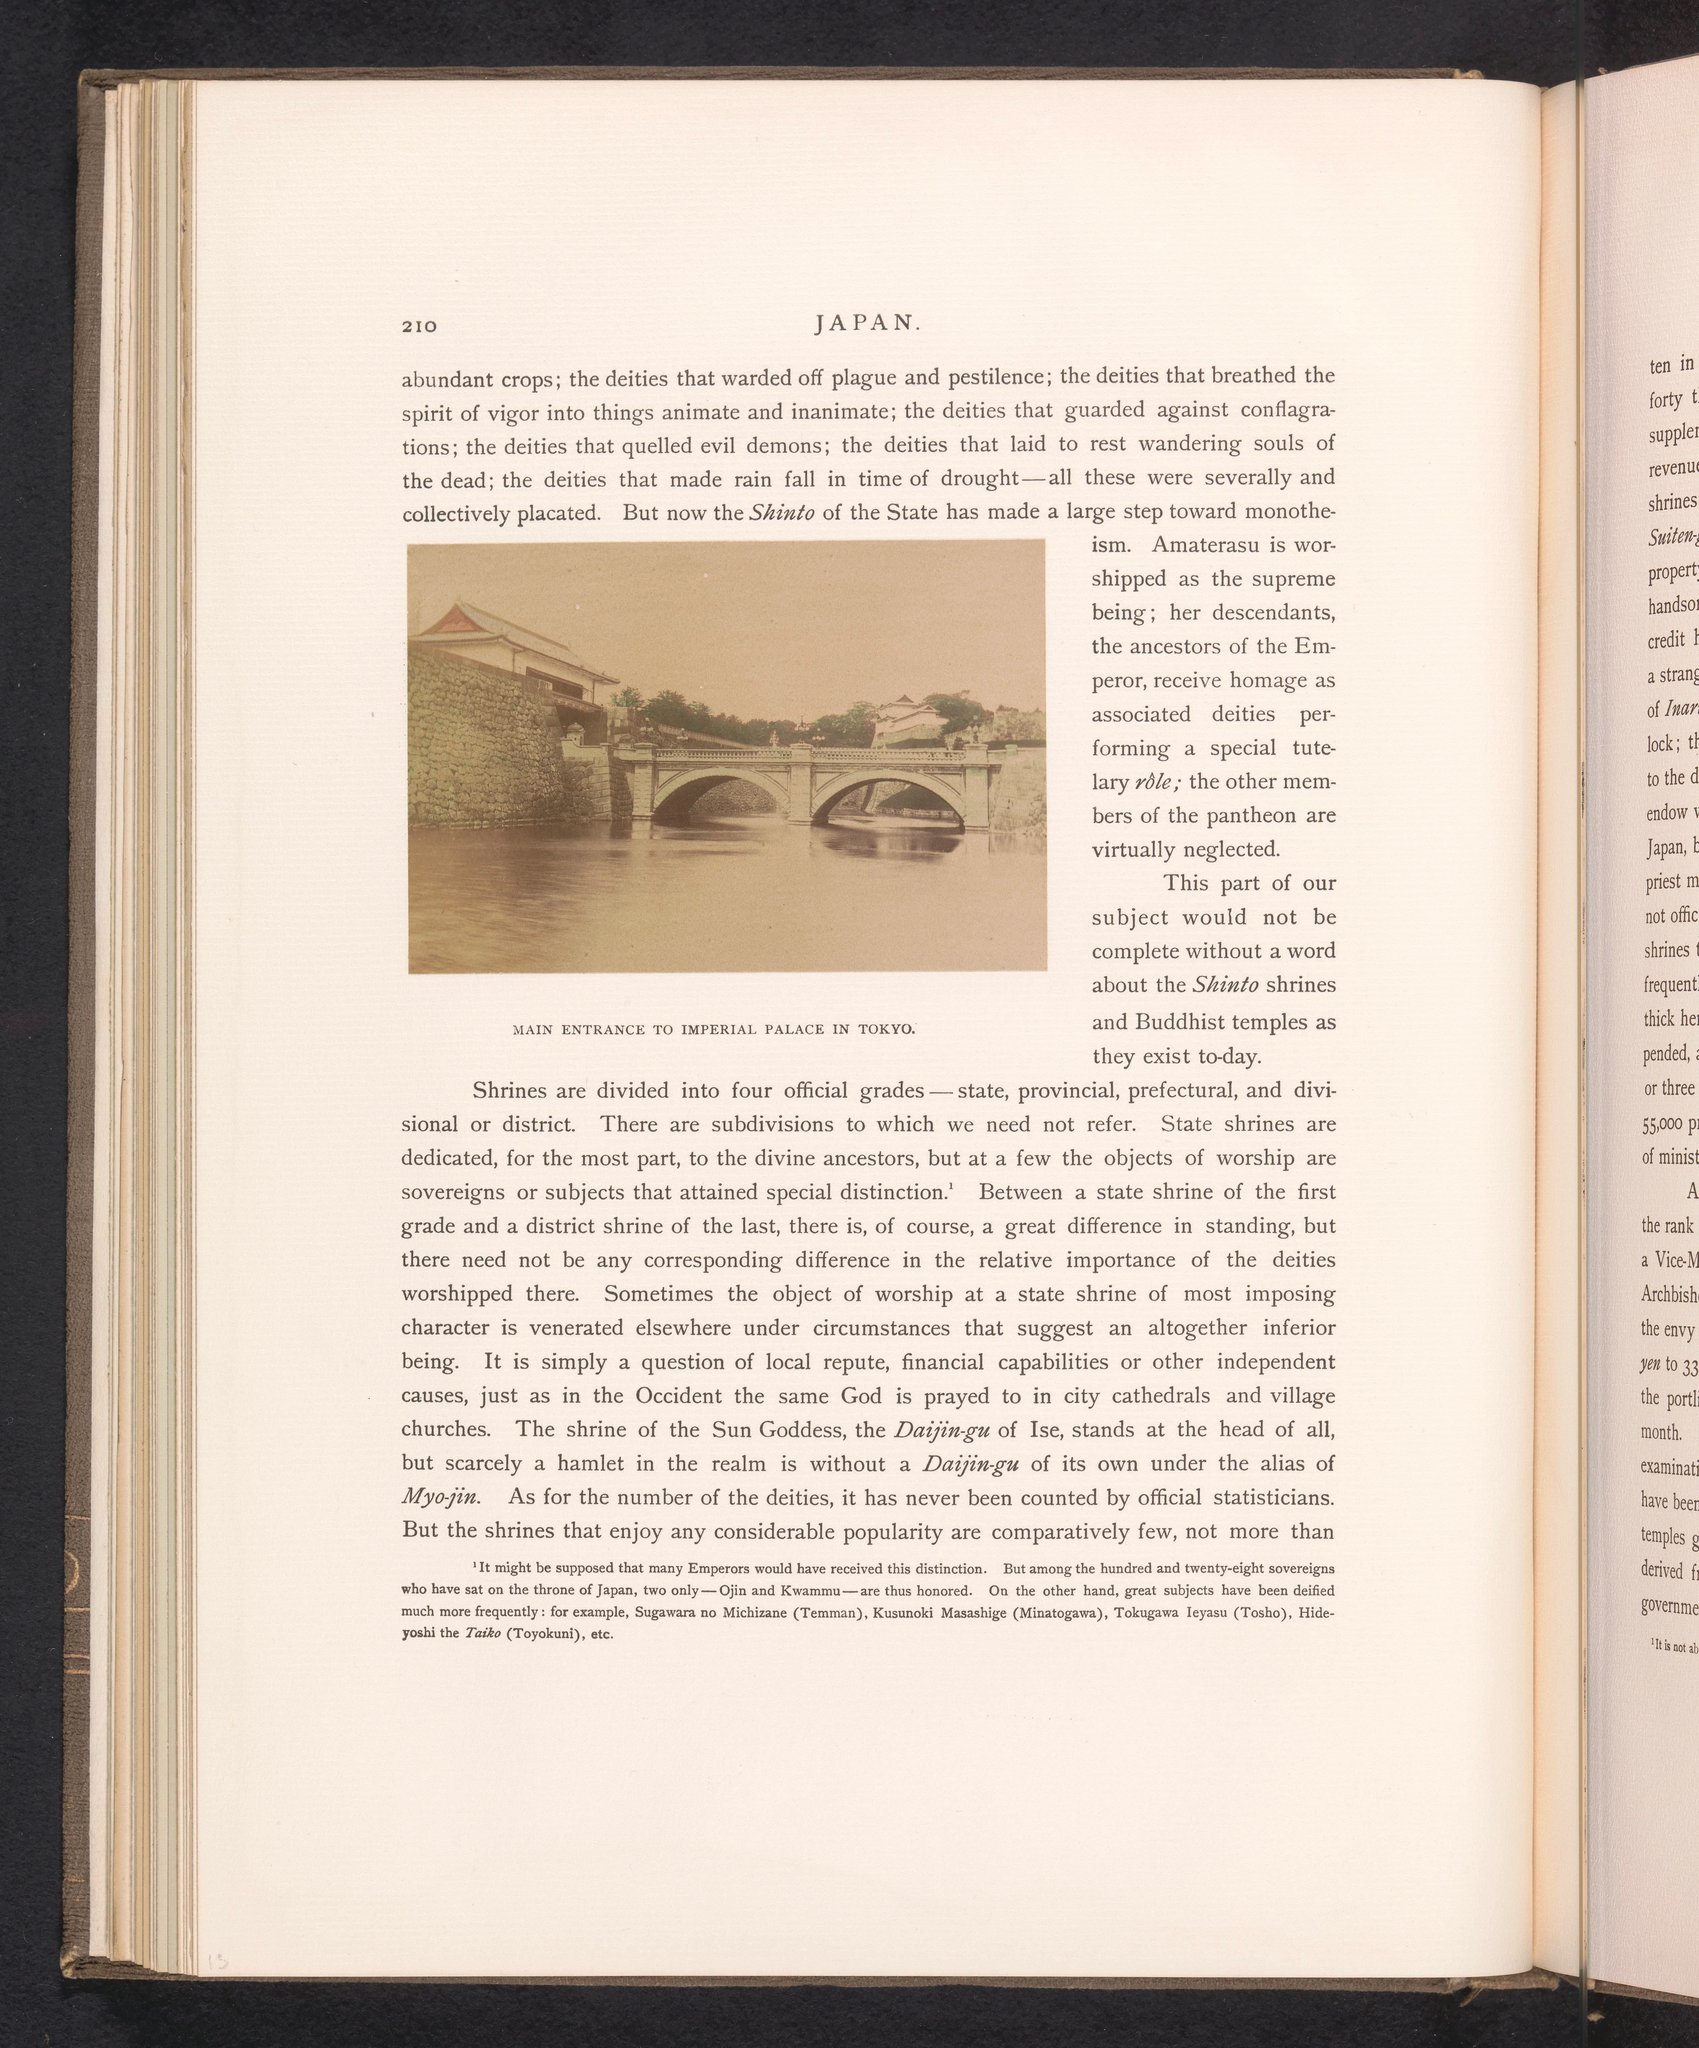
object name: page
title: Main entrance to Imperial Palace in Tokyo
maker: Anonymous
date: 1887-1897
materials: photographic support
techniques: albumen print, hand coloring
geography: tokyo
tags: moat ~ fortified city, bridge